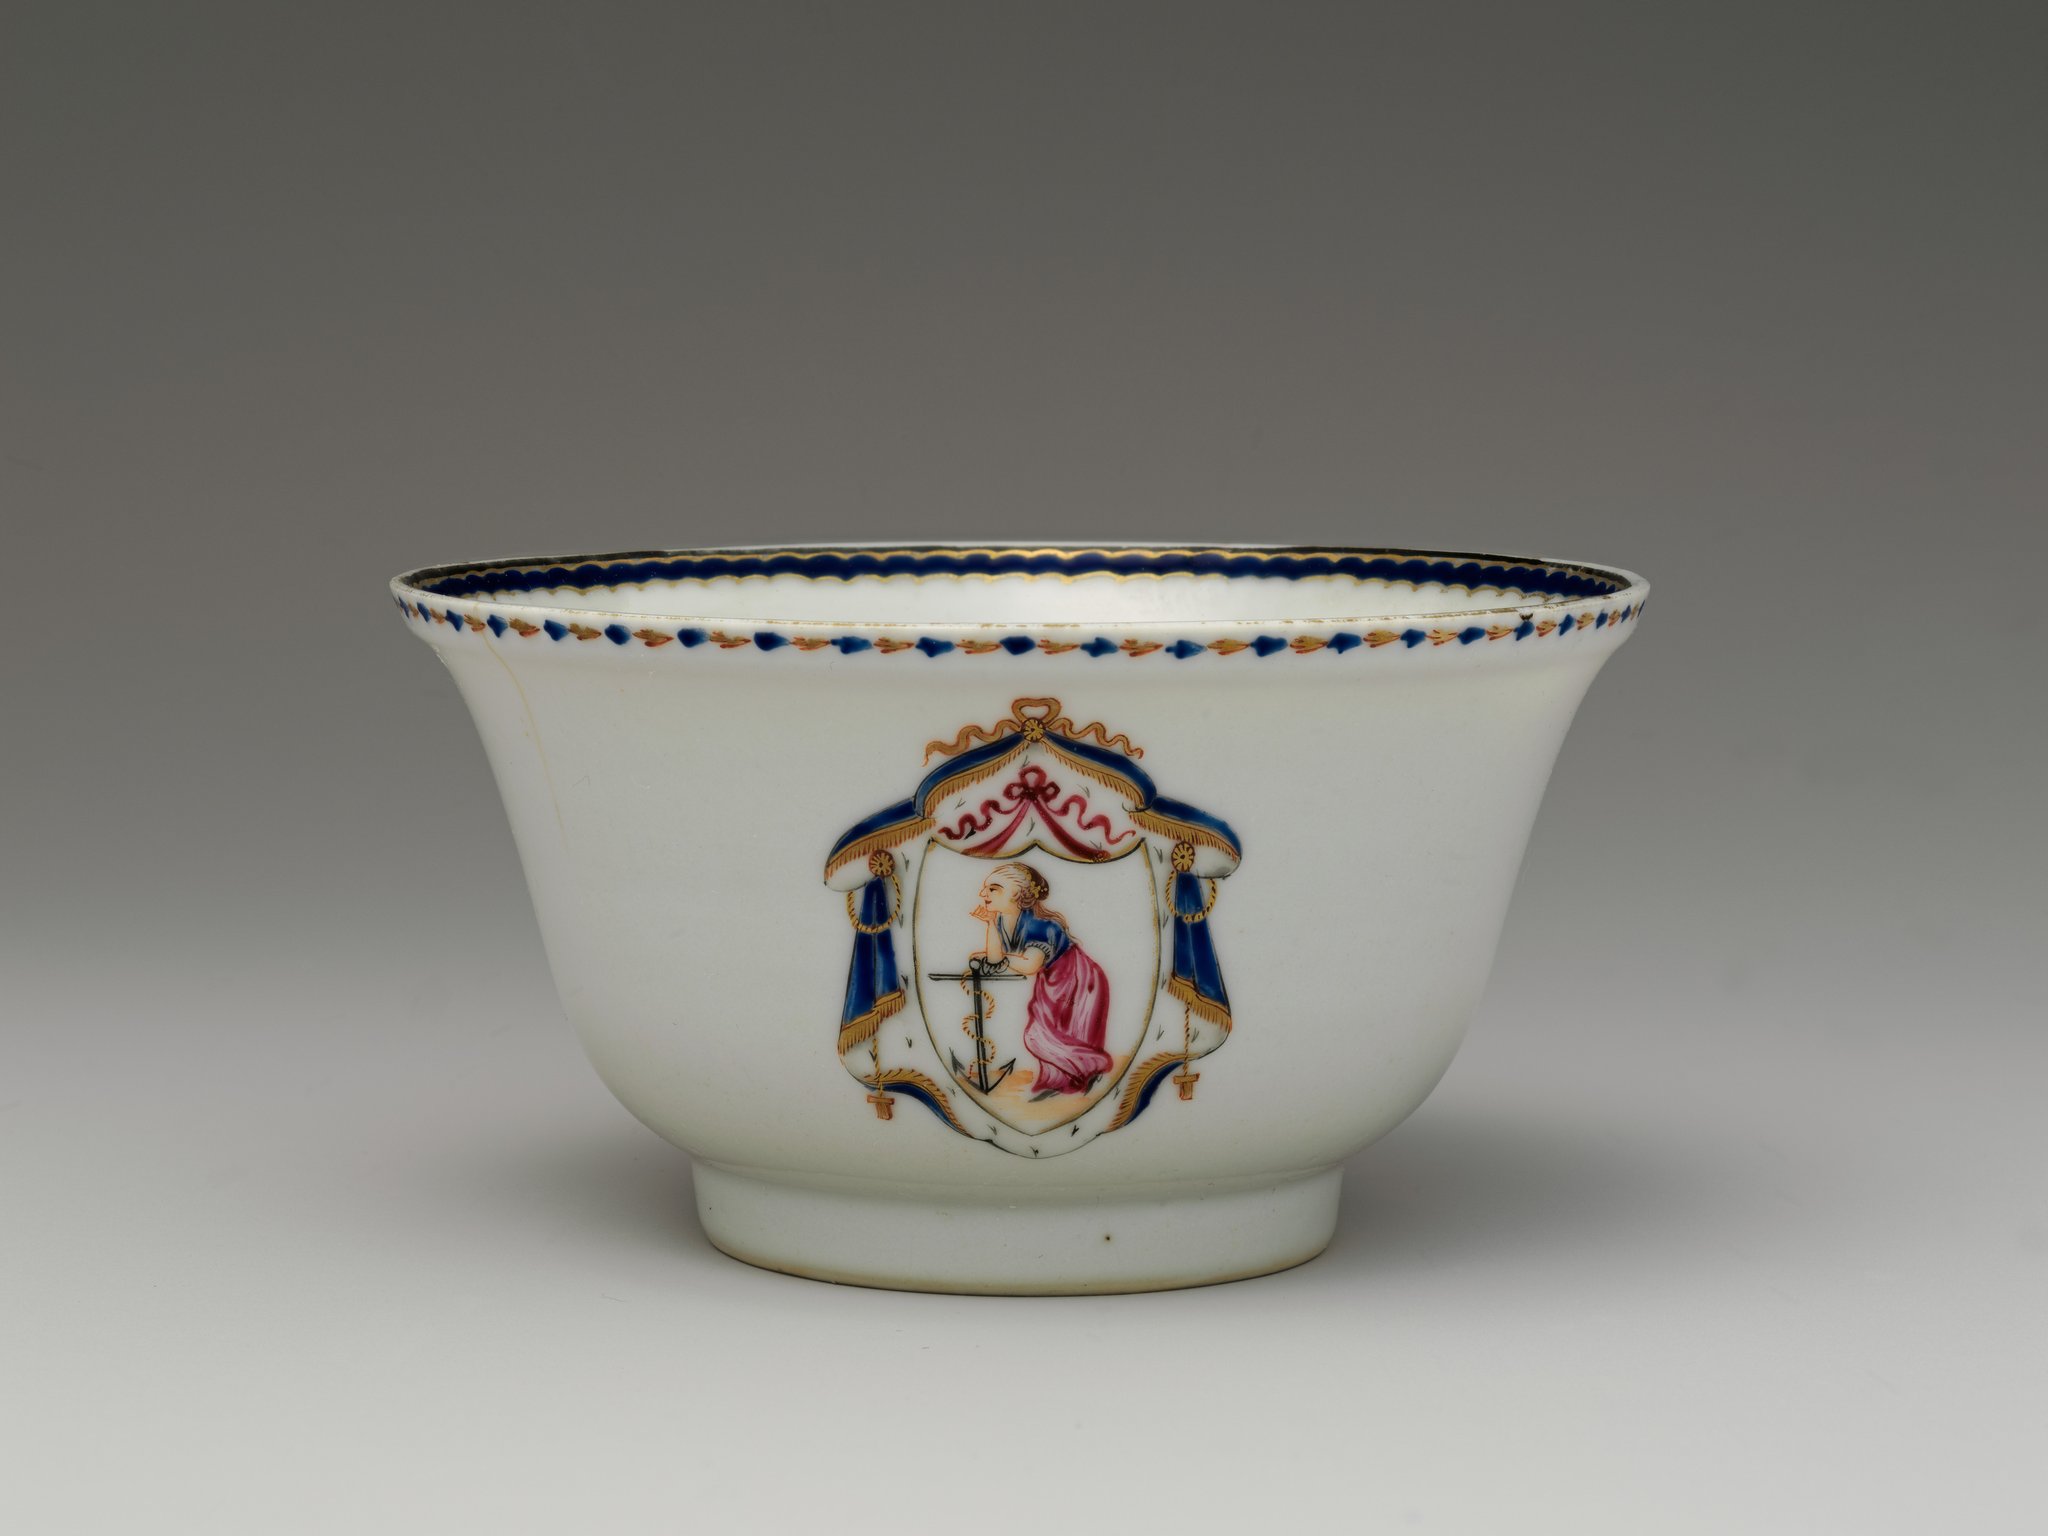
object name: bowl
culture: chinese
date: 1700-1800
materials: porcelain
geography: china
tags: coat of arms